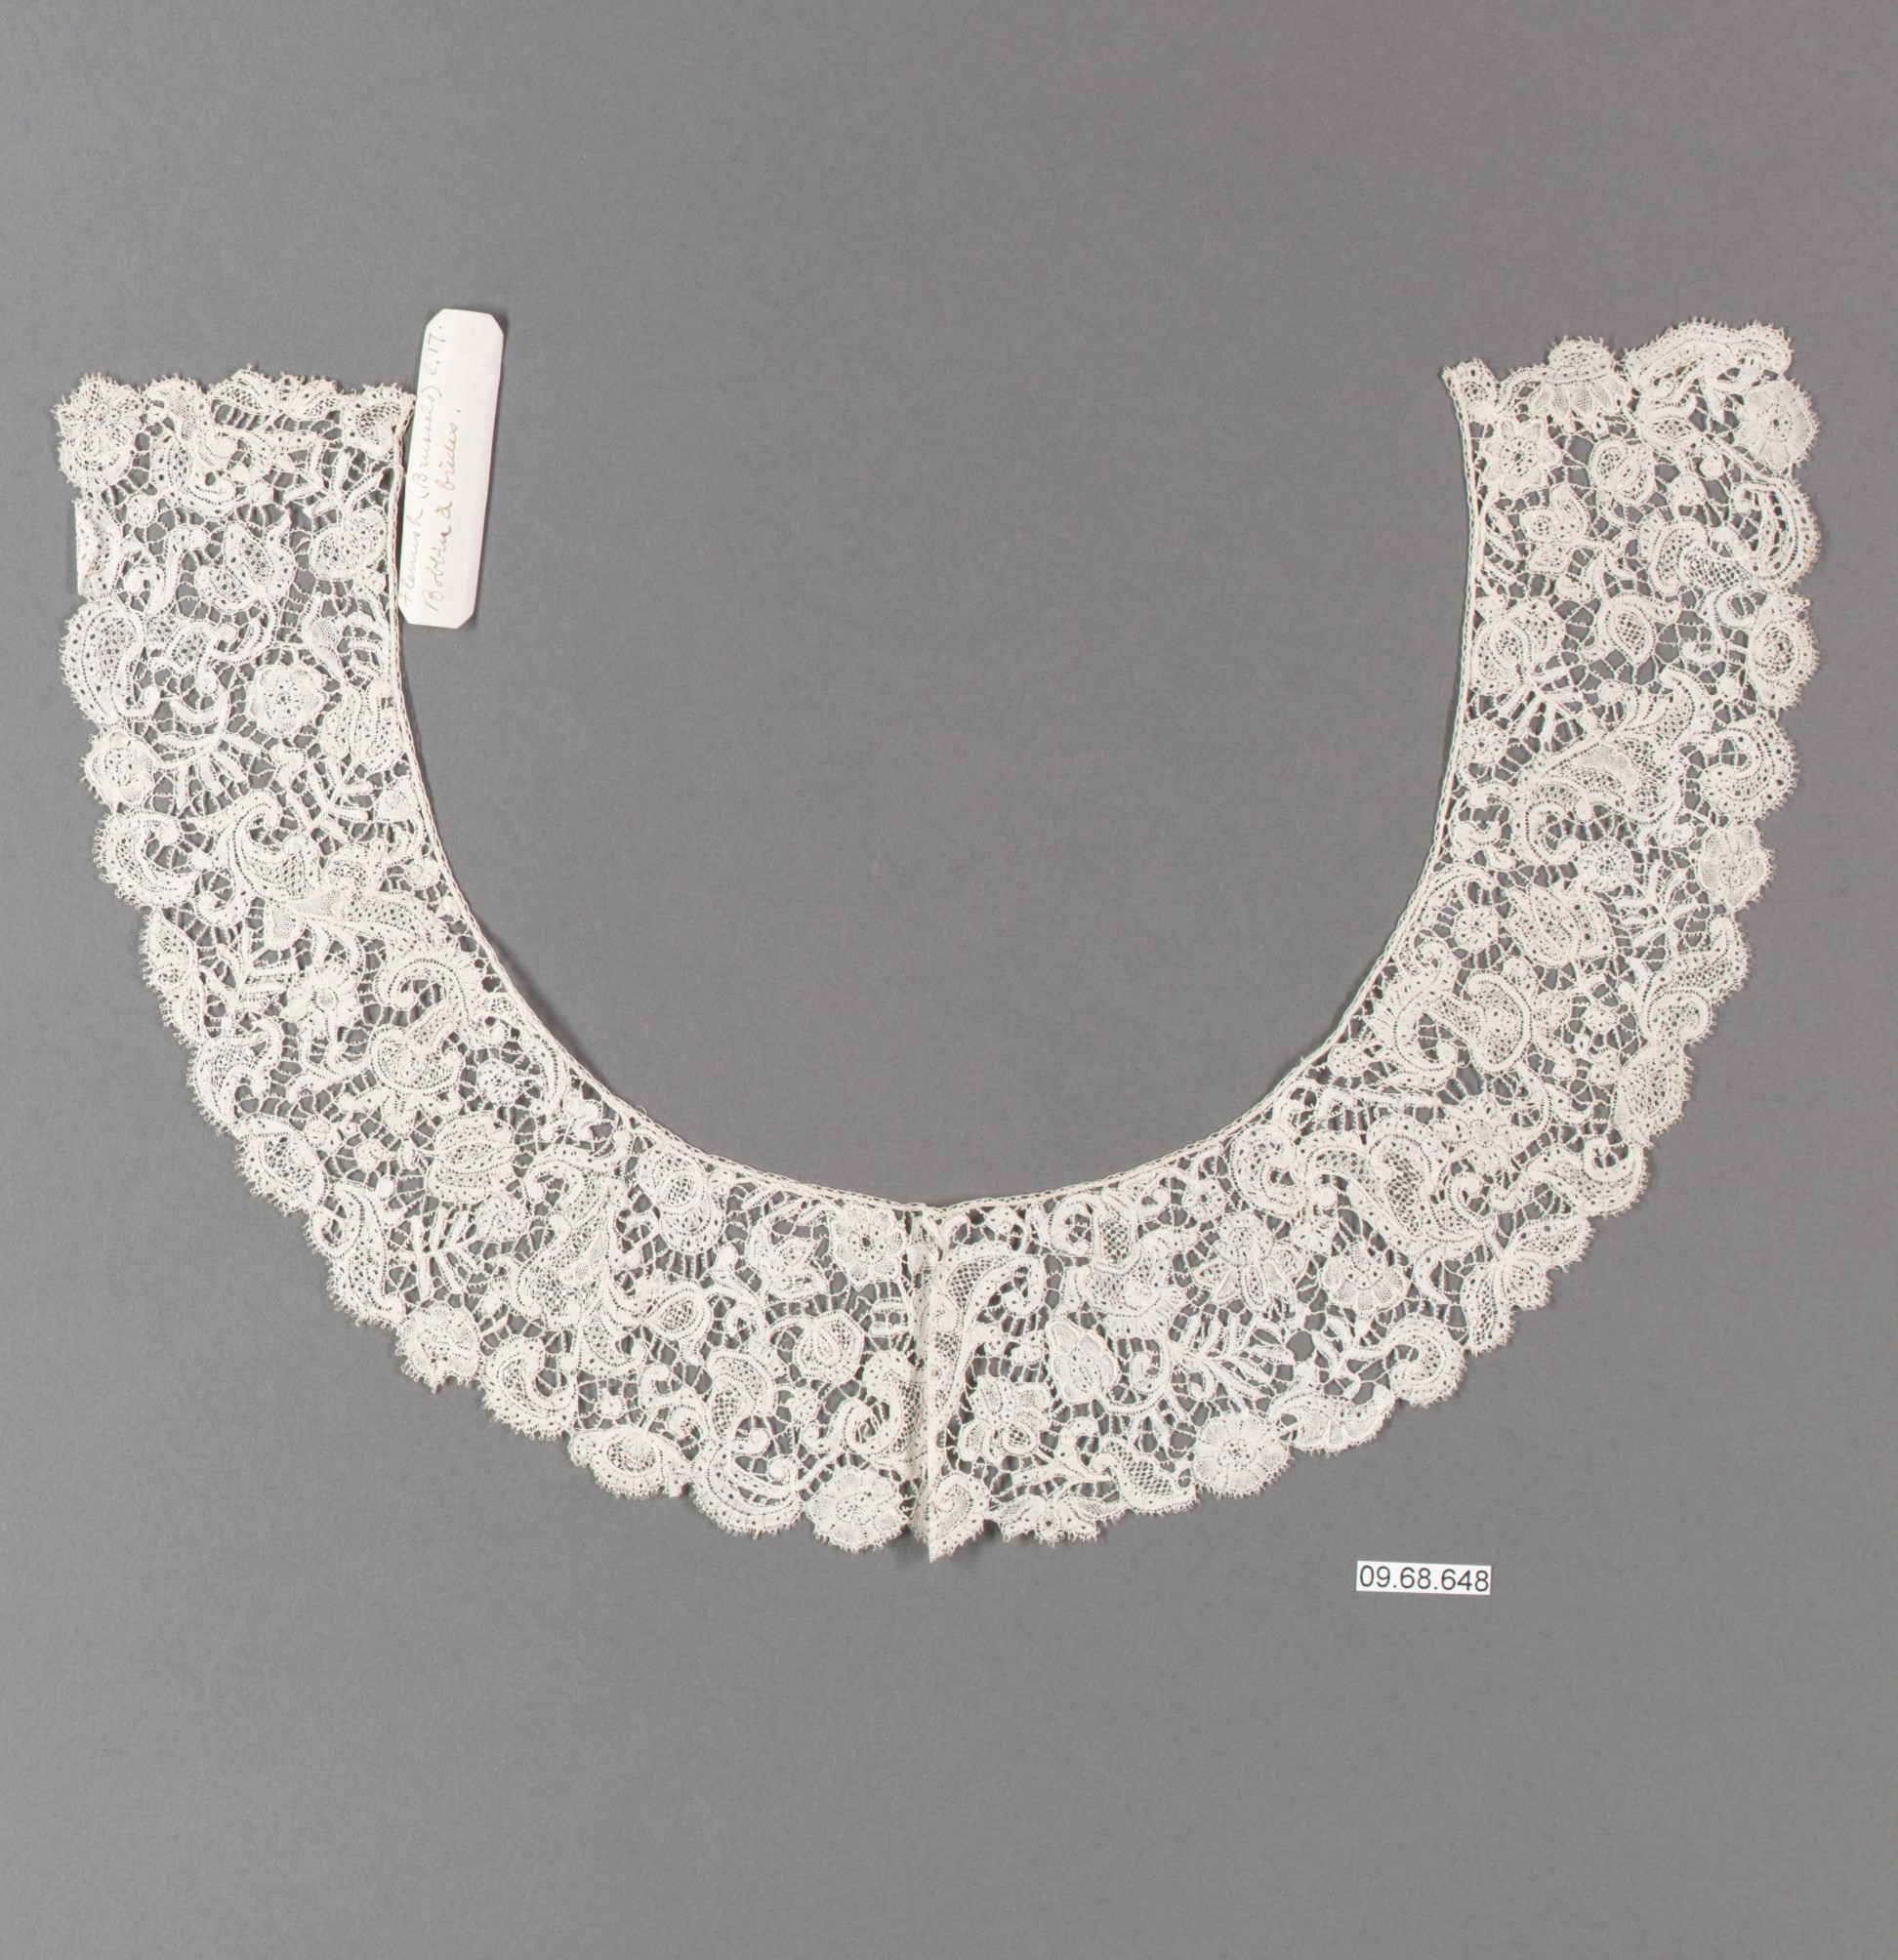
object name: collar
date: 1667-1700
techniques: lace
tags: flowers